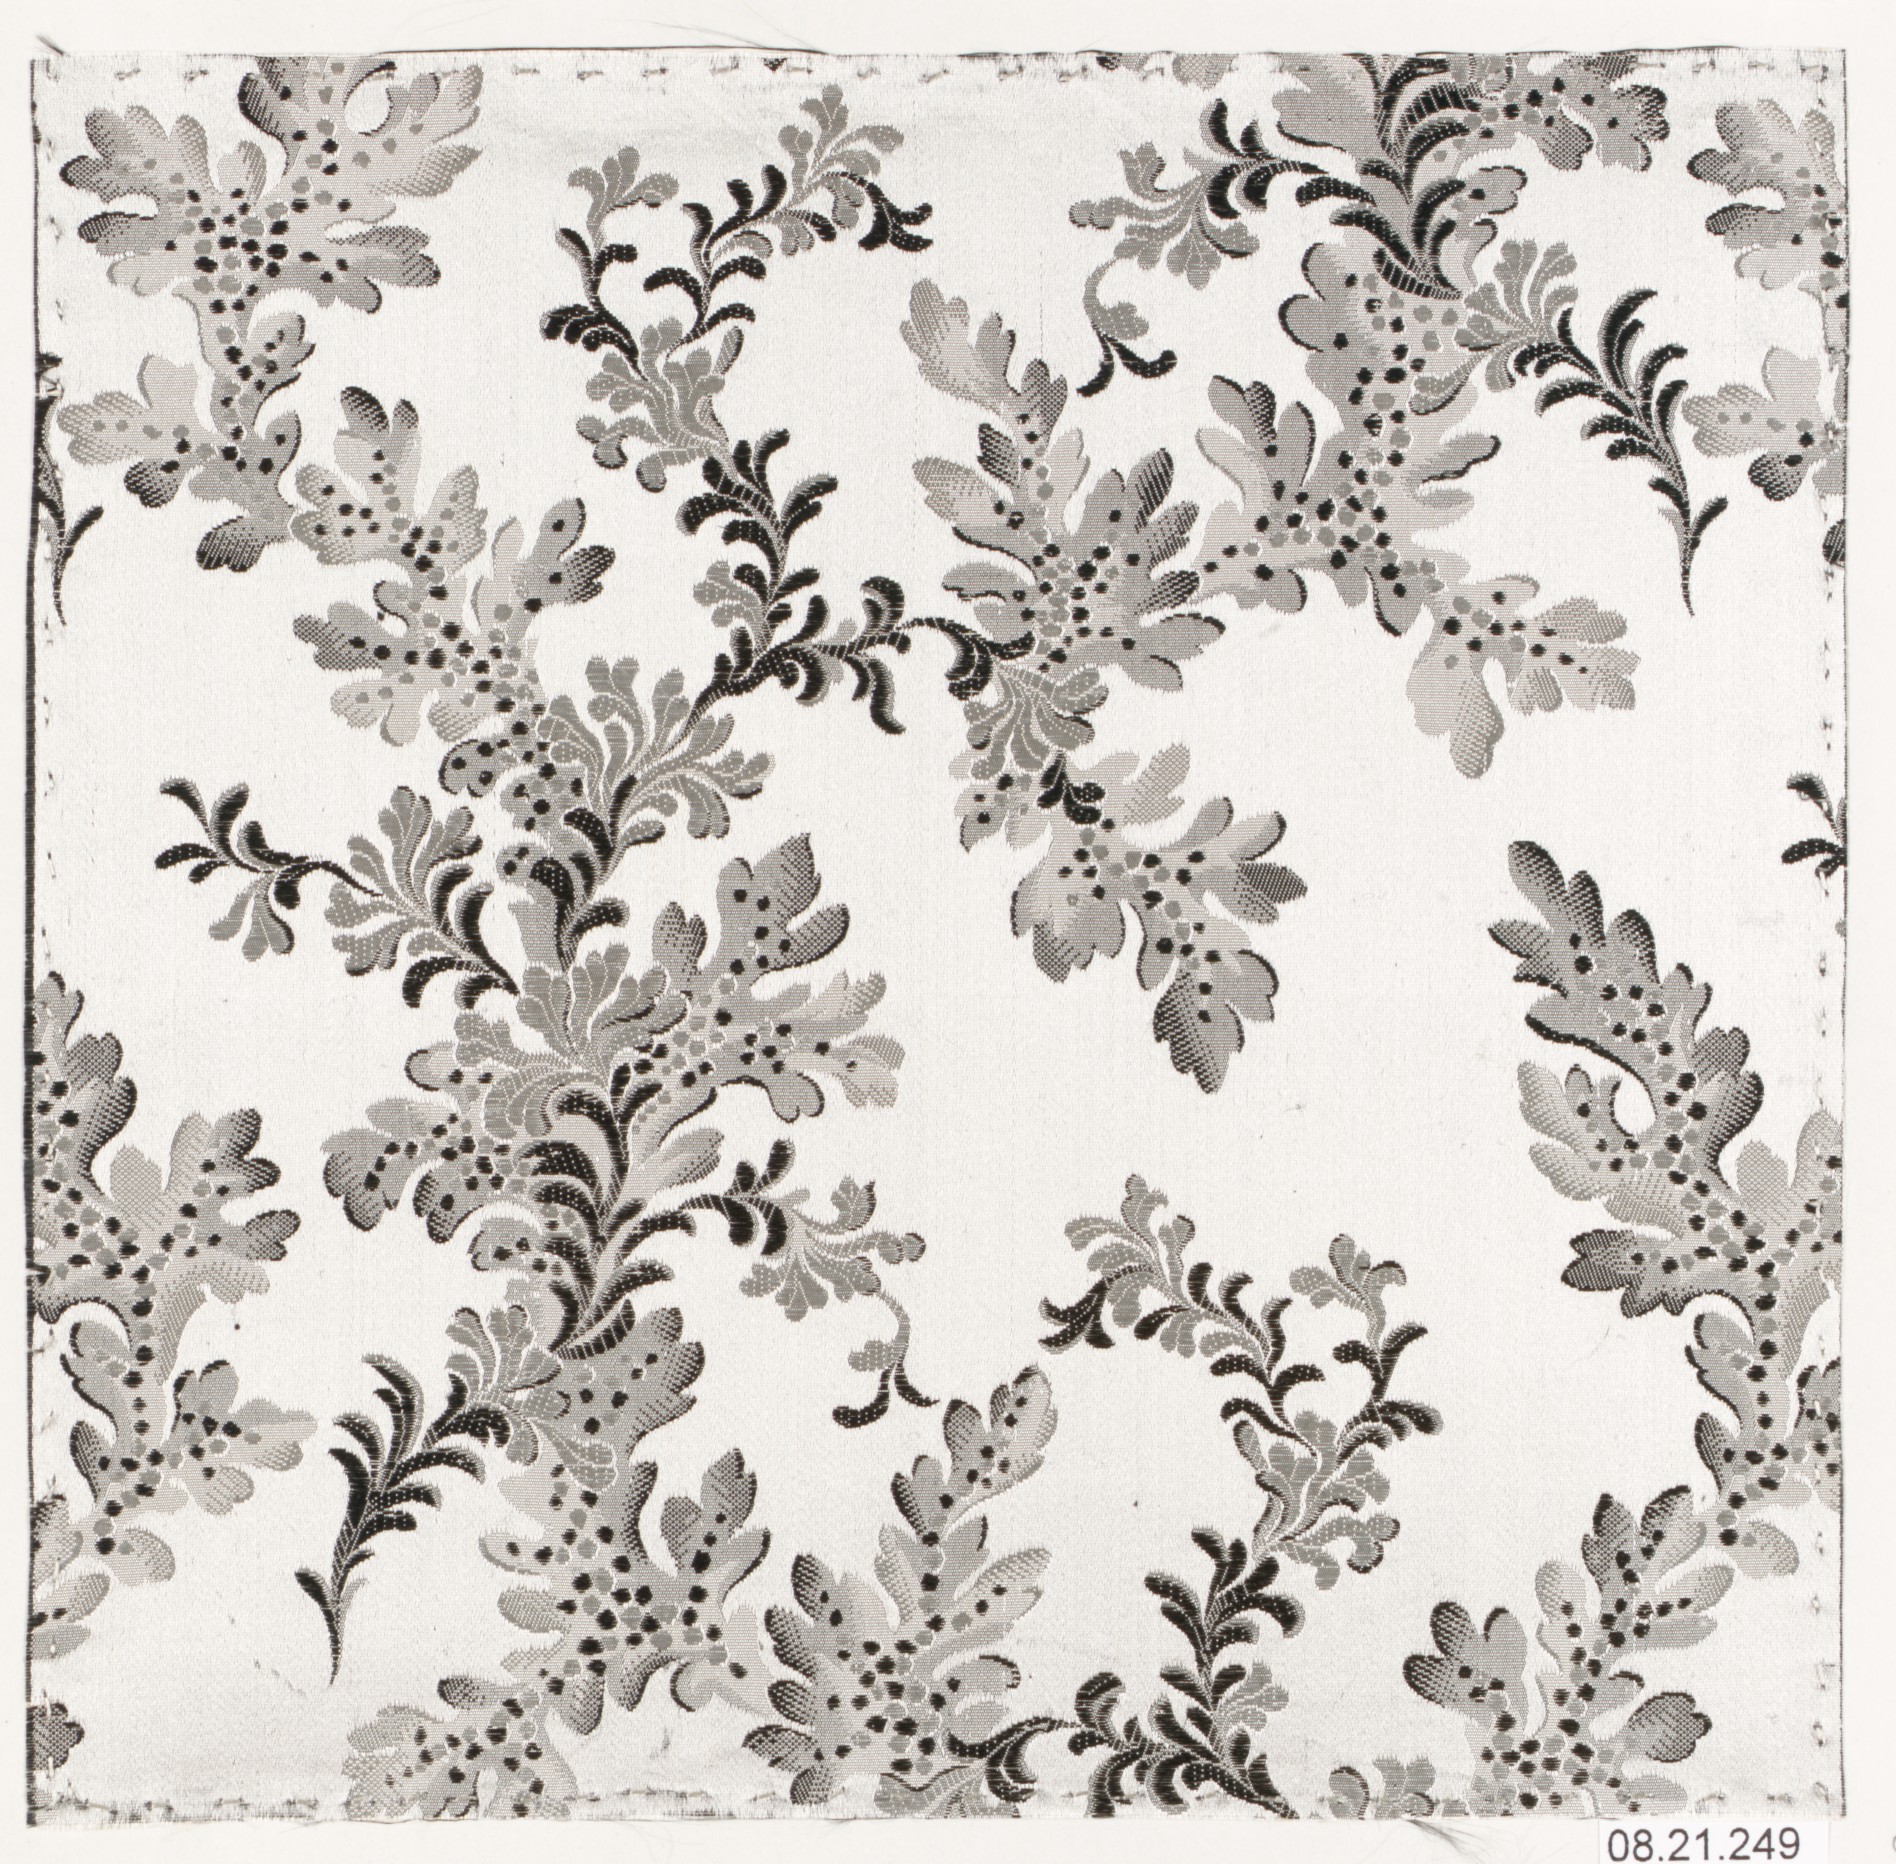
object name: textile sample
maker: Anonymous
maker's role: designer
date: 1900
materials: silk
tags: leaves